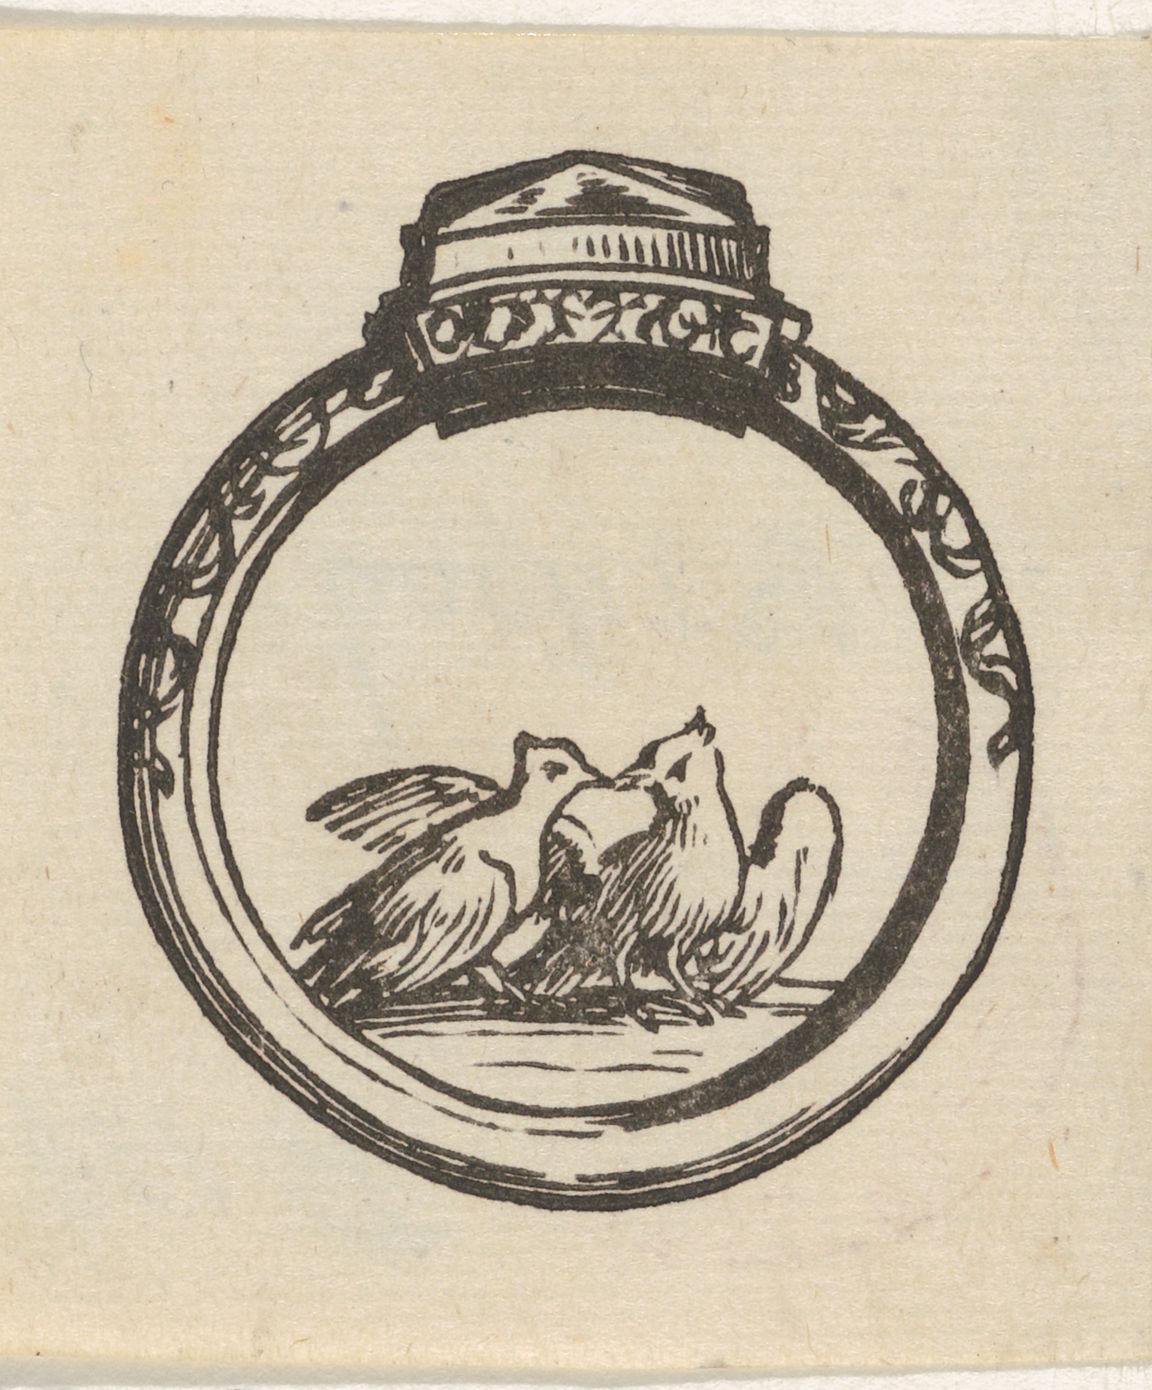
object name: print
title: Twee tortelduiven in een ring met een steen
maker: dirck de bray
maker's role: draughtsman, painter, print maker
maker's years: 1625-1694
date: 1635-1694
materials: paper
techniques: woodcut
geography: netherlands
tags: ring, other birds: turtle dove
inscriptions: collector's mark: Lugt 240